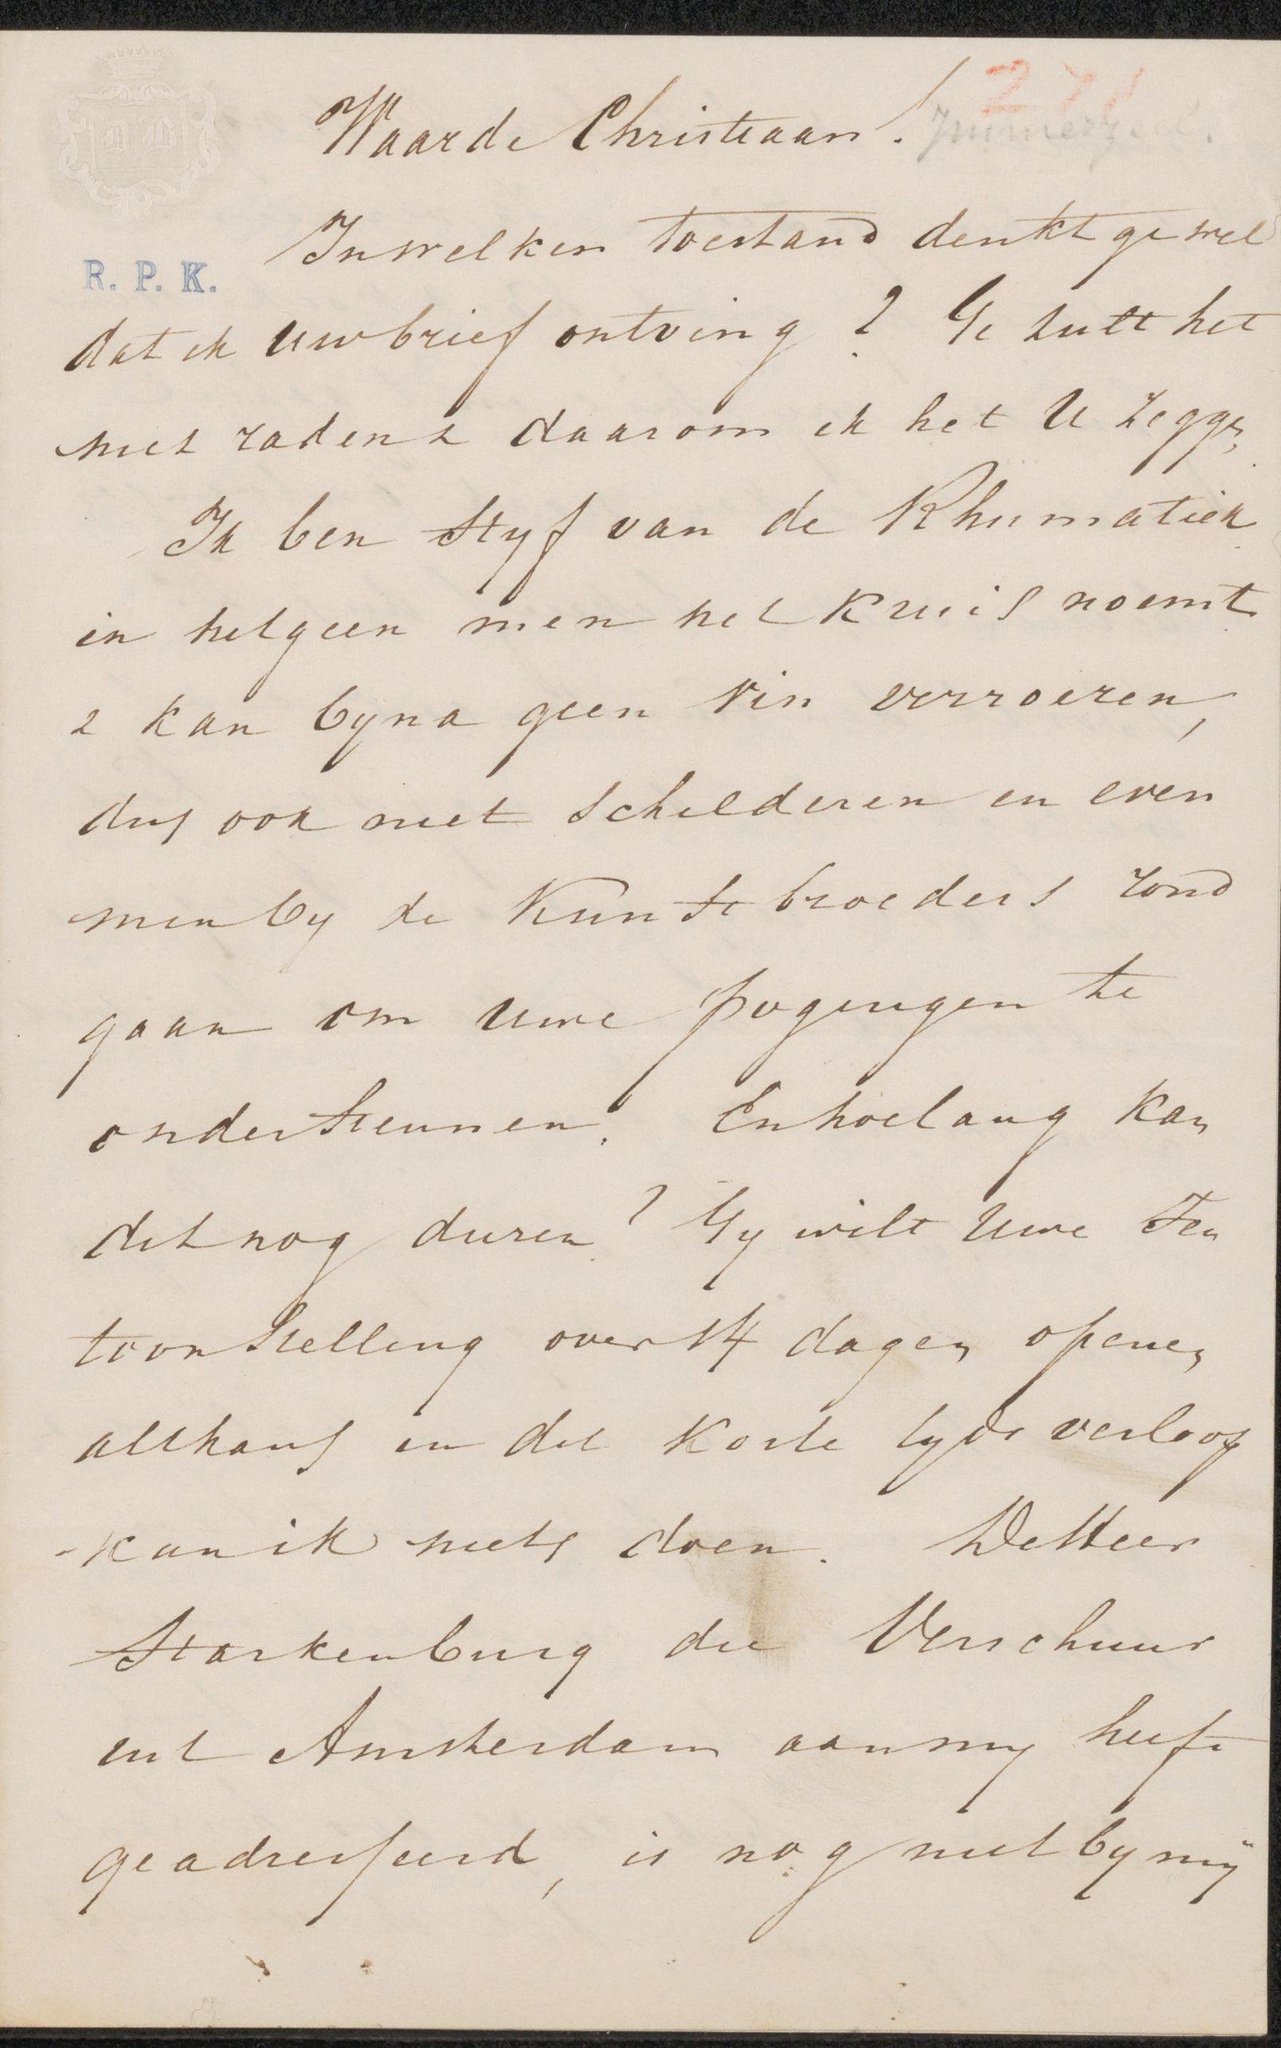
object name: letter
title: Brief aan Christiaan Immerzeel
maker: adrianus hendrikus de bruine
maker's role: amateurschilder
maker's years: 1807-1870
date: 1835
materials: ink, paper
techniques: pen, writing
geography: cleves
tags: christiaan immerzeel, middelburg, cleves, painter, print maker, draughtsman, barend cornelis koekkoek, painting (including book-illumination, miniature-painting), exhibition ~ art, diseases, amsterdam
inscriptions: collector's mark: Lugt 2233, monogram